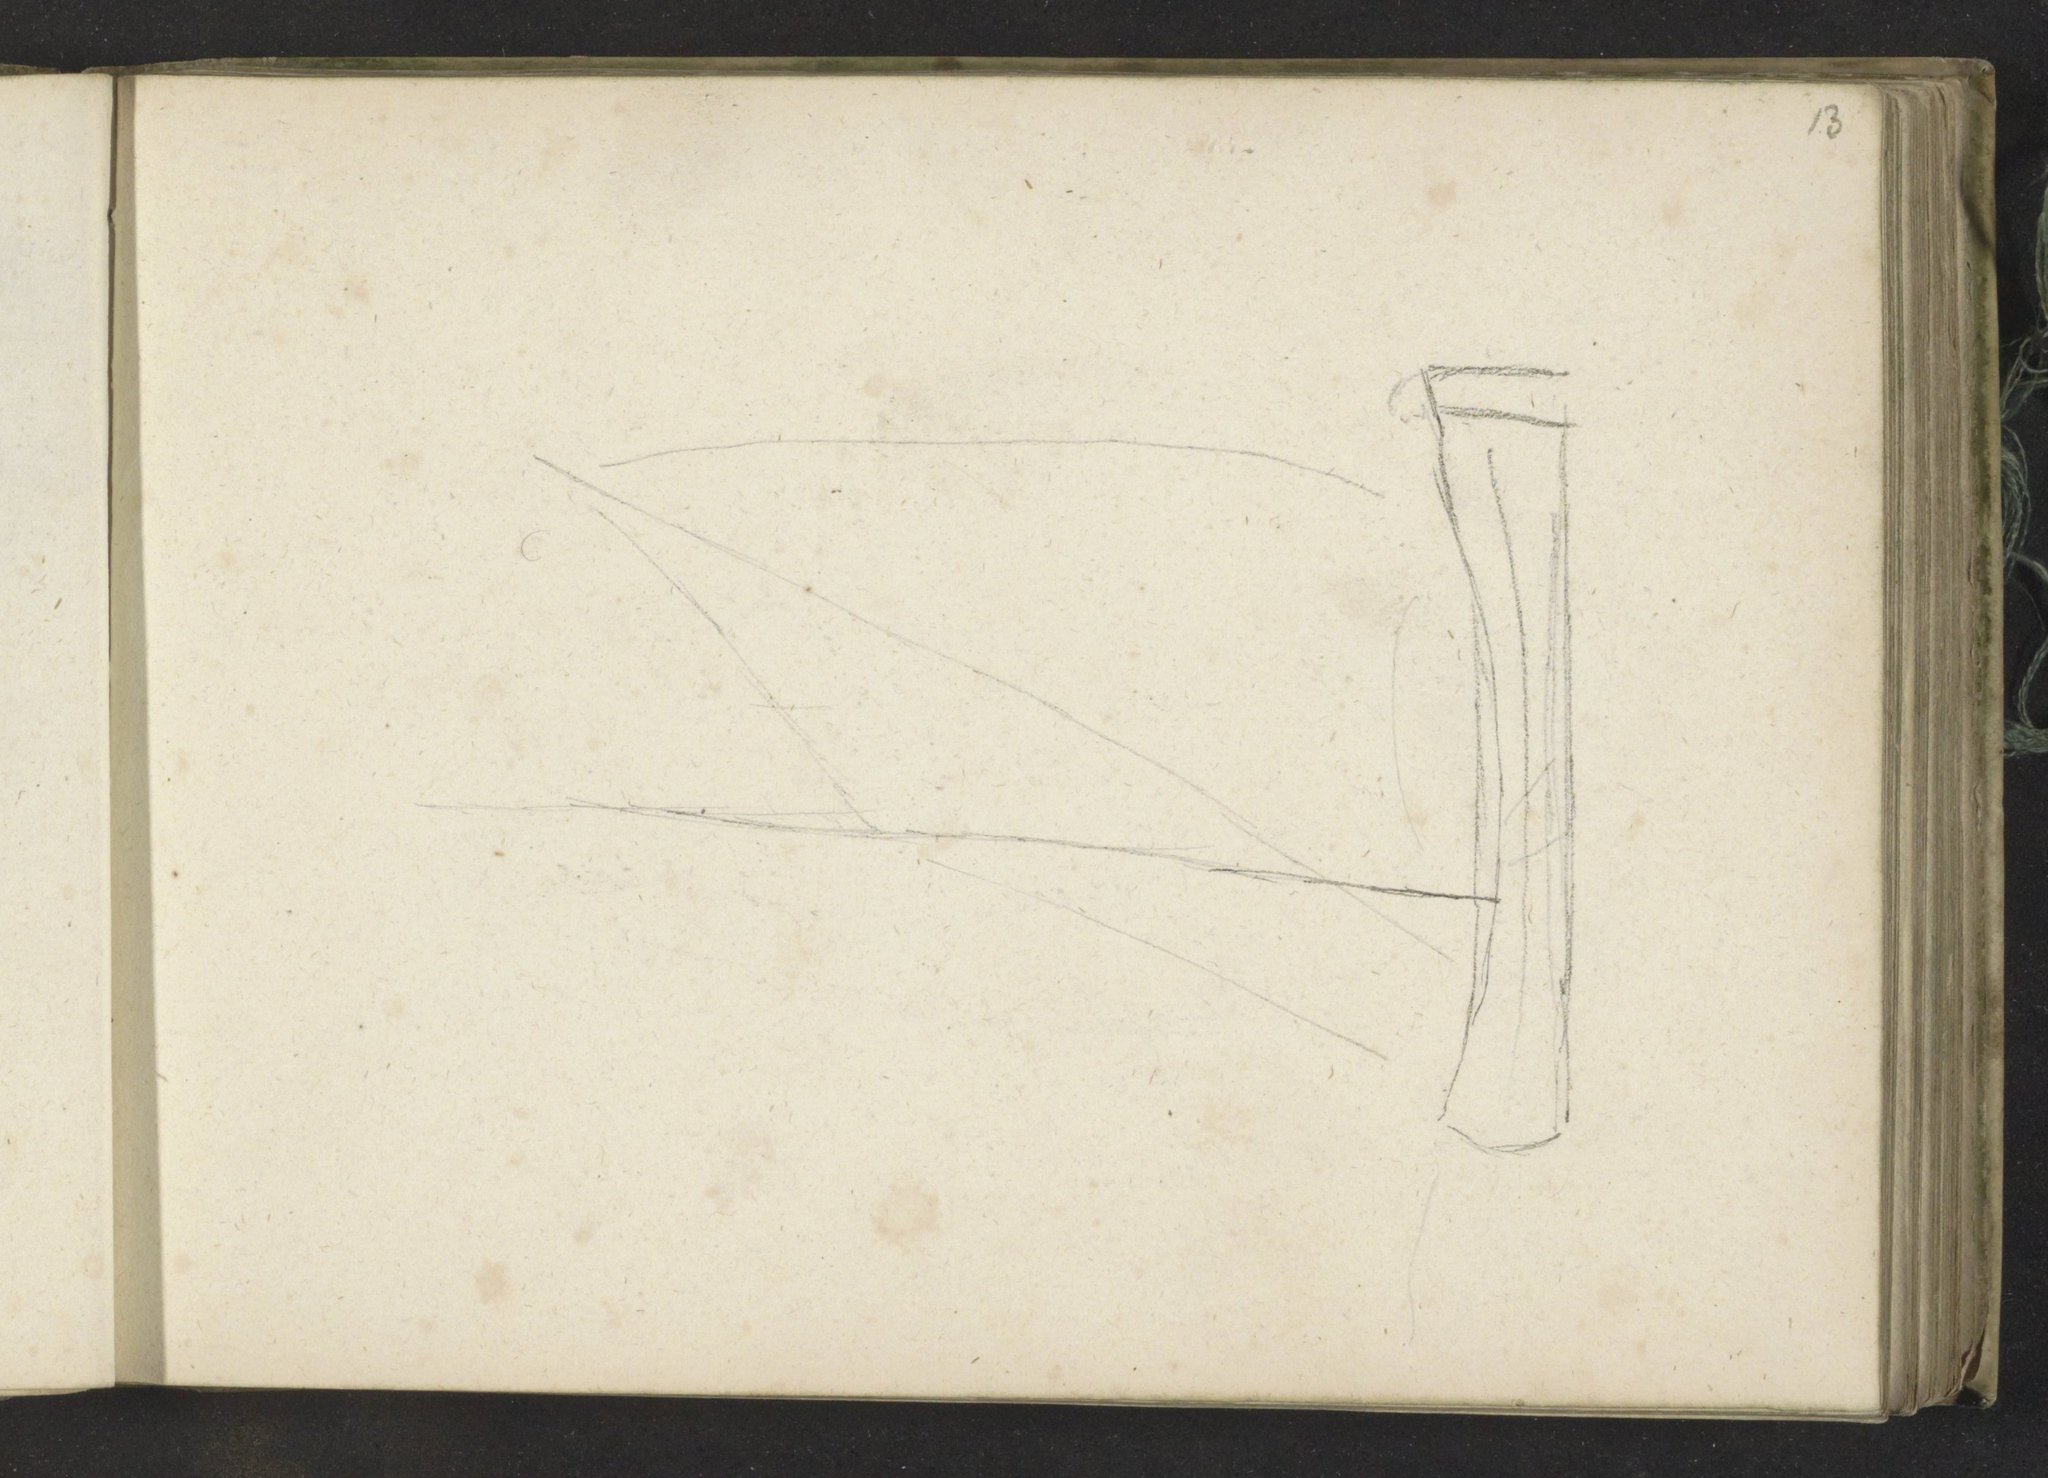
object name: sketchbook leaf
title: Zeilboot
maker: martinus schouman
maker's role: draughtsman, painter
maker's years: 1770-1848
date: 1780-1848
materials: paper, pencil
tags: sailing-ship, sailing-boat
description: Blad 13 recto uit een schetsboek met 53 bladen.